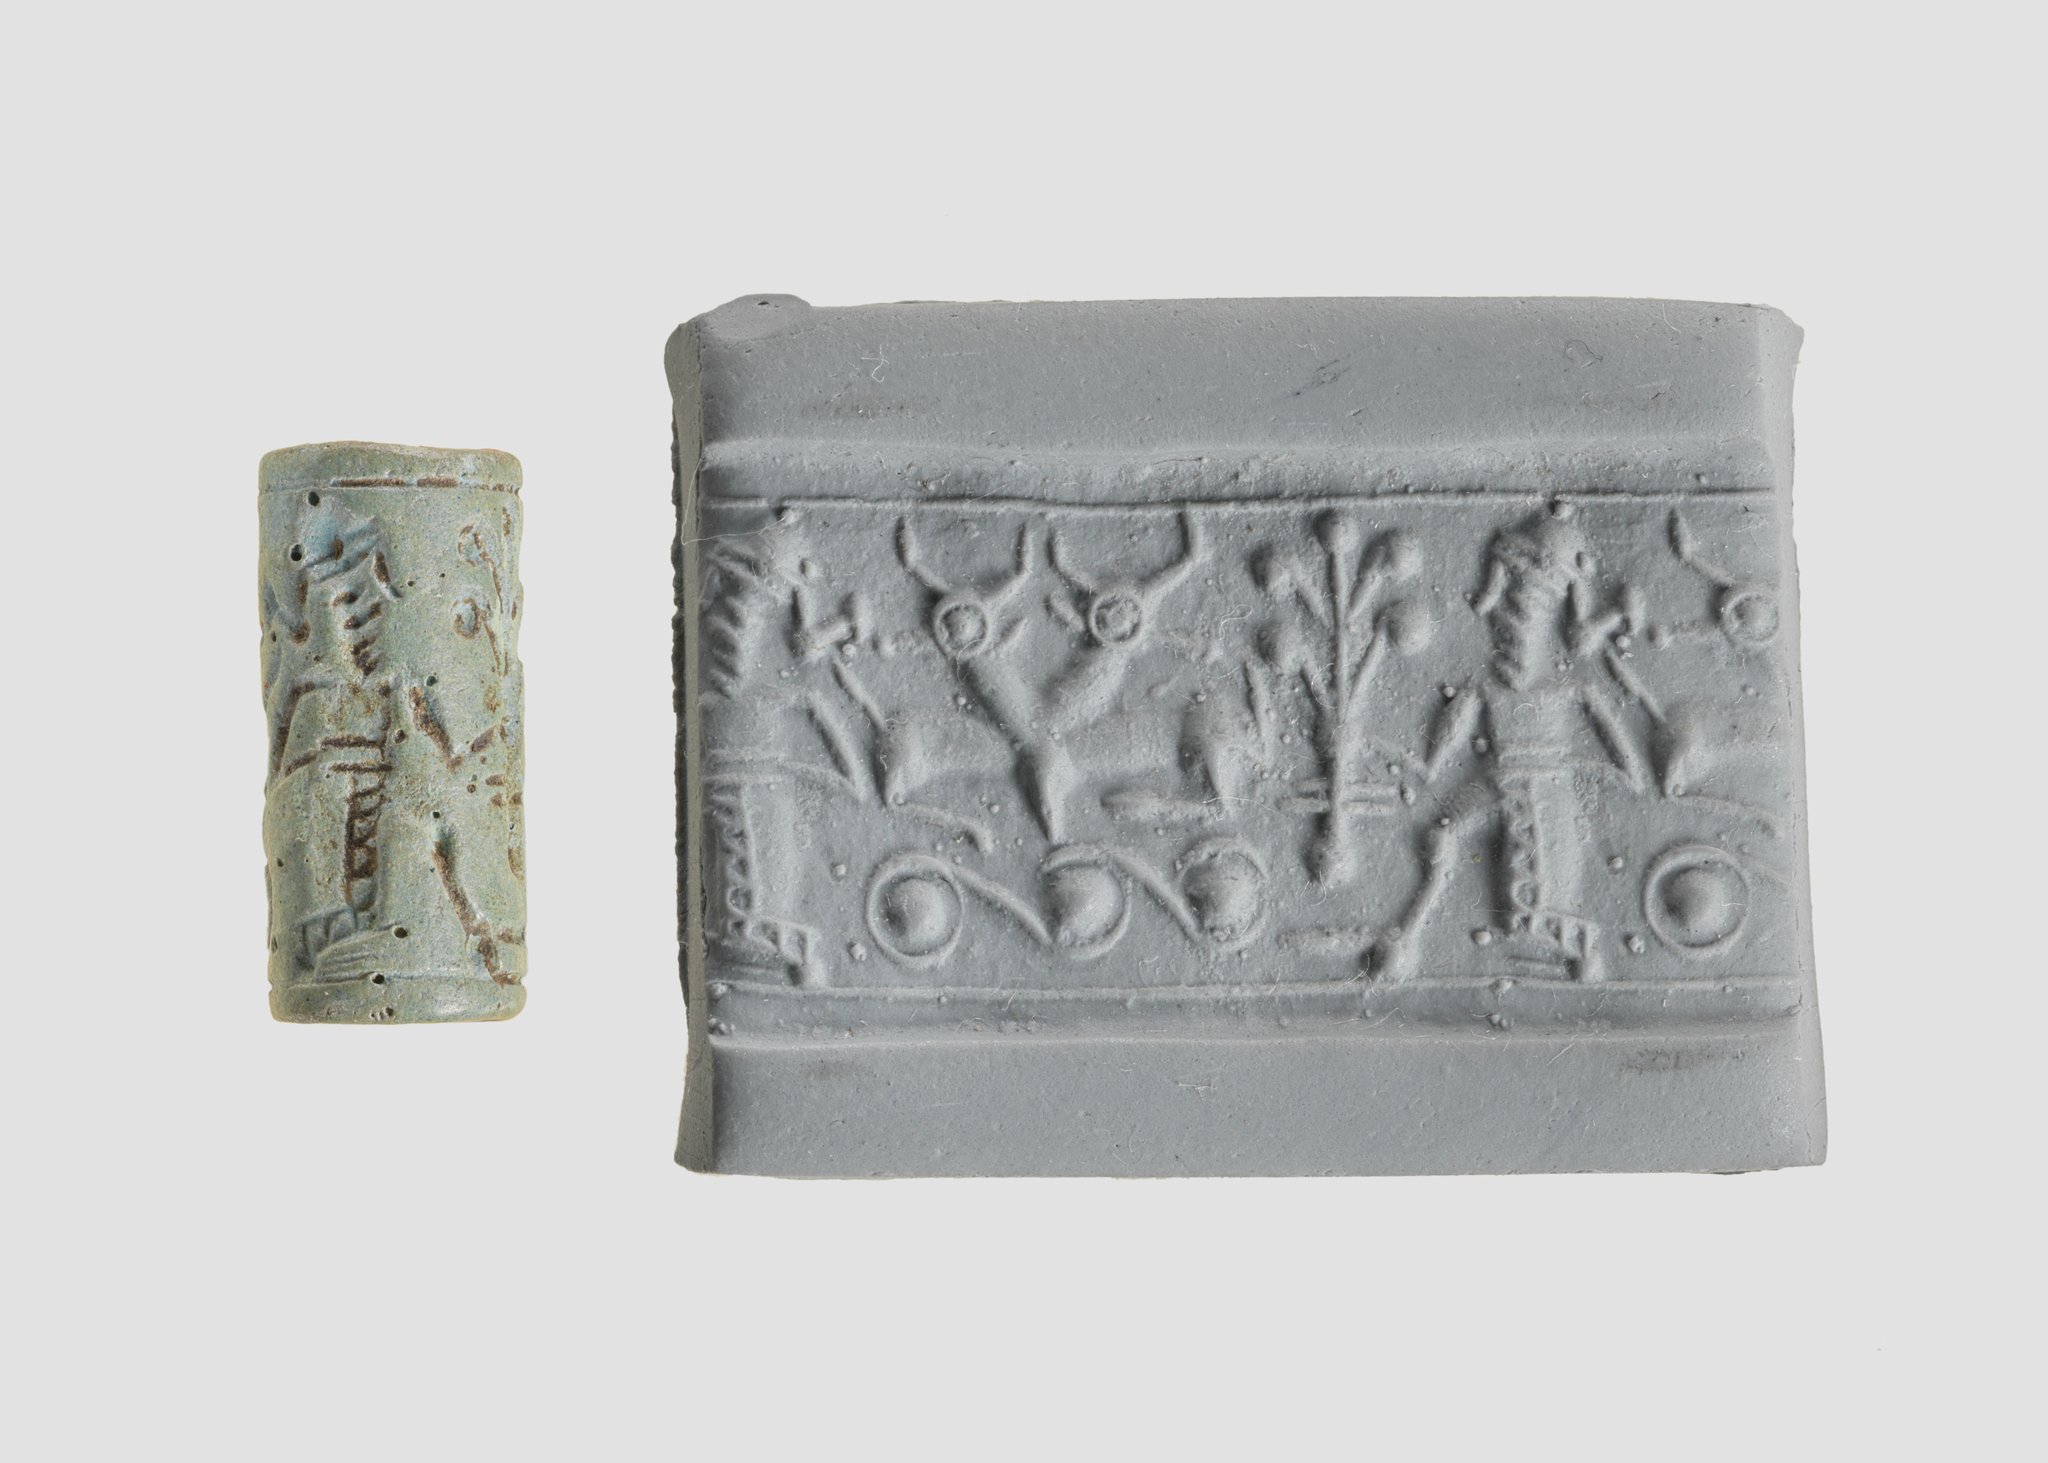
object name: cylinder seal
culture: mitanni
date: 1500-1301 BCE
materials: faience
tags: animals